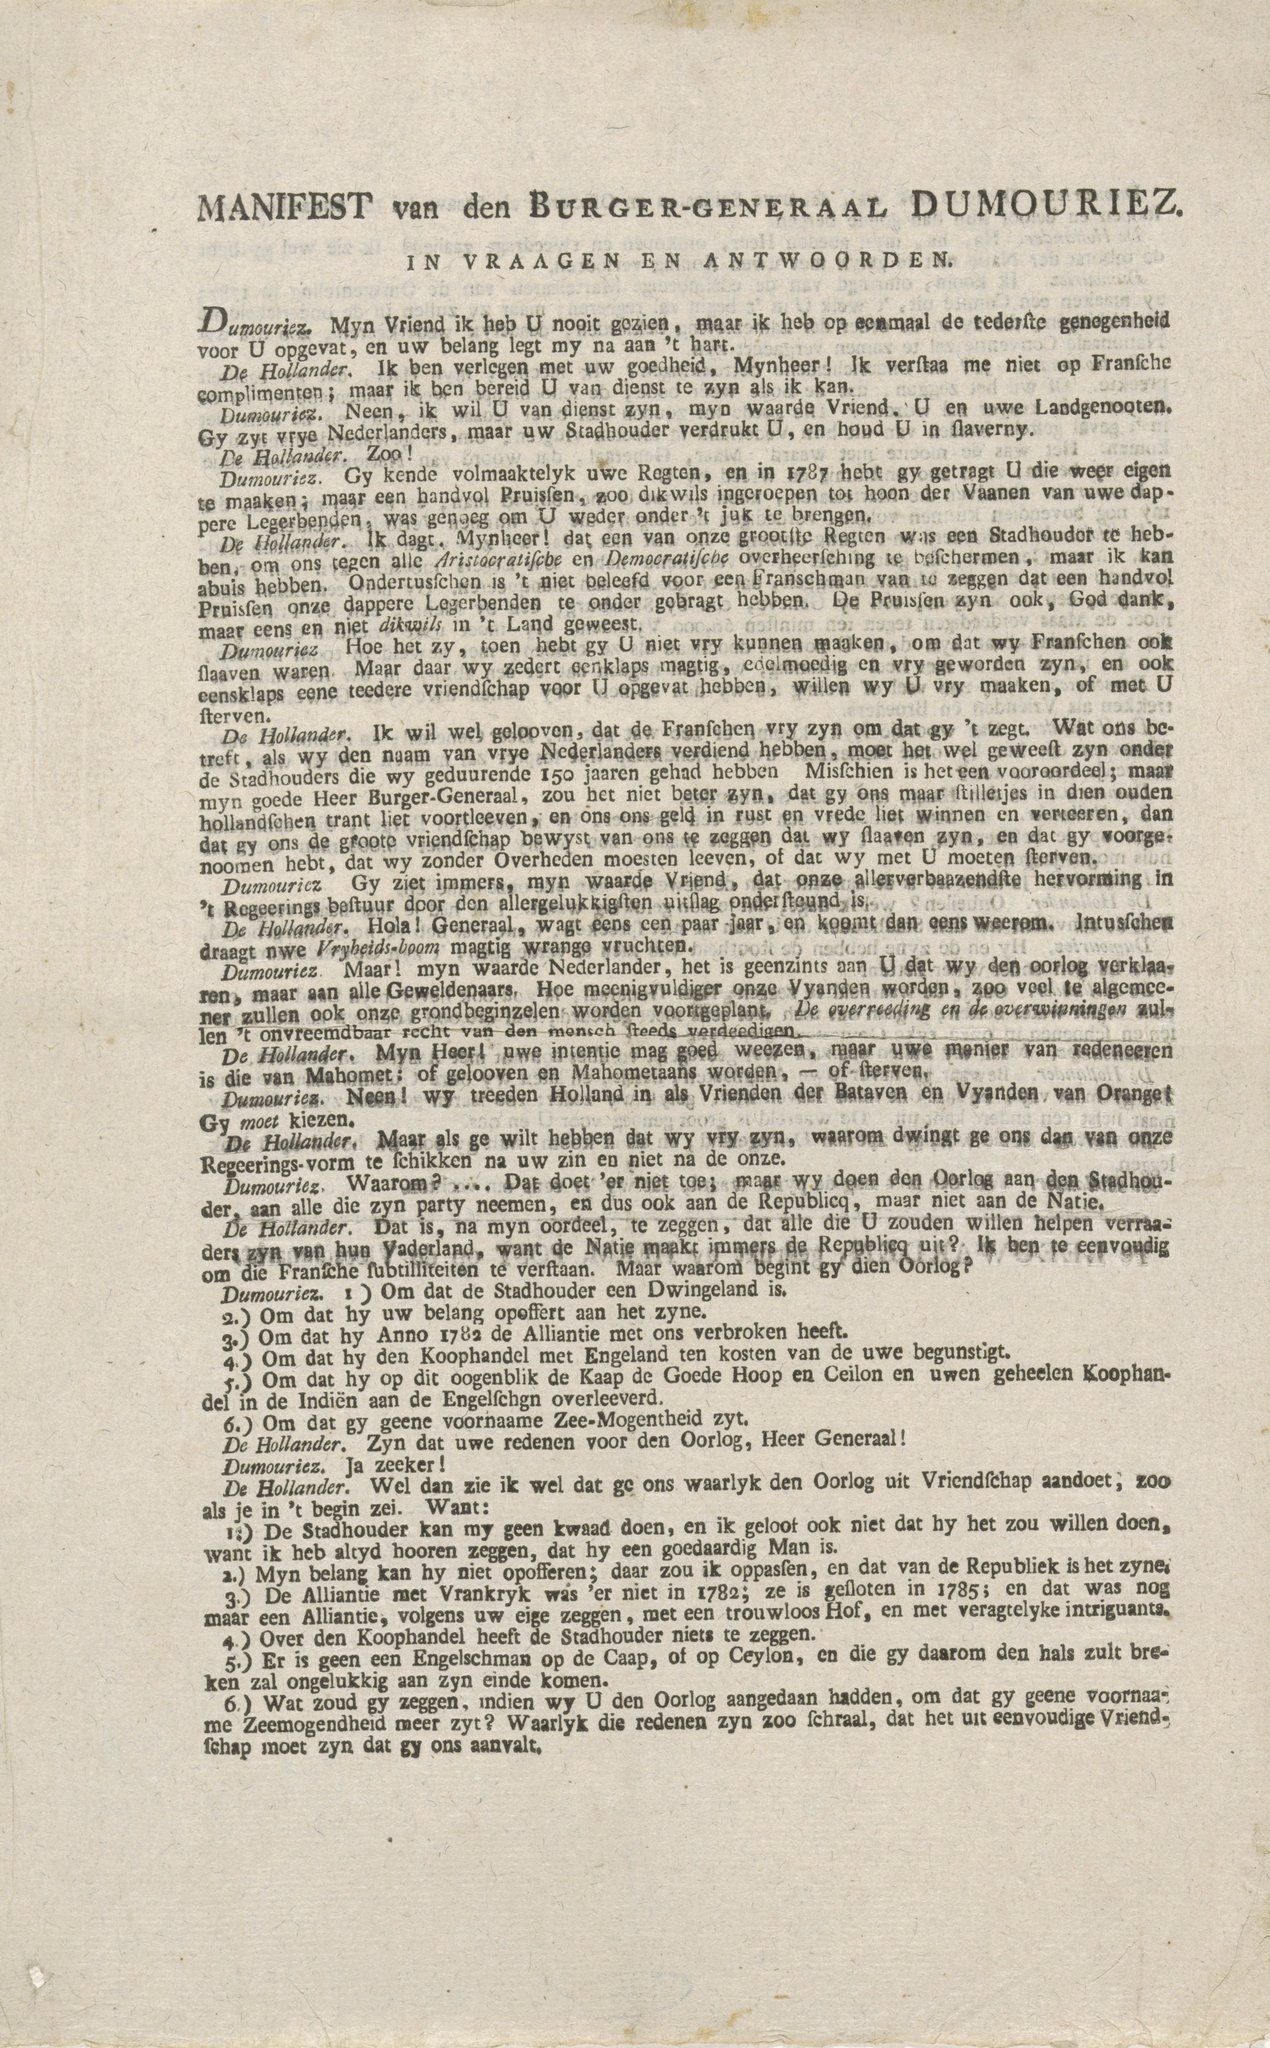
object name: text sheet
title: Manifest van den Burger-Generaal Dumouriez. In vraagen en Antwoorden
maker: harmen post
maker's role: printer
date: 1793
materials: paper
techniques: letterpress printing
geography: leeuwarden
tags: cambrai, turville, generaal, minister, staatsman, diplomaat, charles françois dumouriez, eerste coalitie-oorlog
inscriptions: collector's mark: Lugt 2228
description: Tekstblad bedrukt op beide zijden met een samenspraak tussen de Franse generaal Charles François Dumouriez en de Hollander. Naar aanleiding van zijn vertrek uit de Nederlanden in 1793.